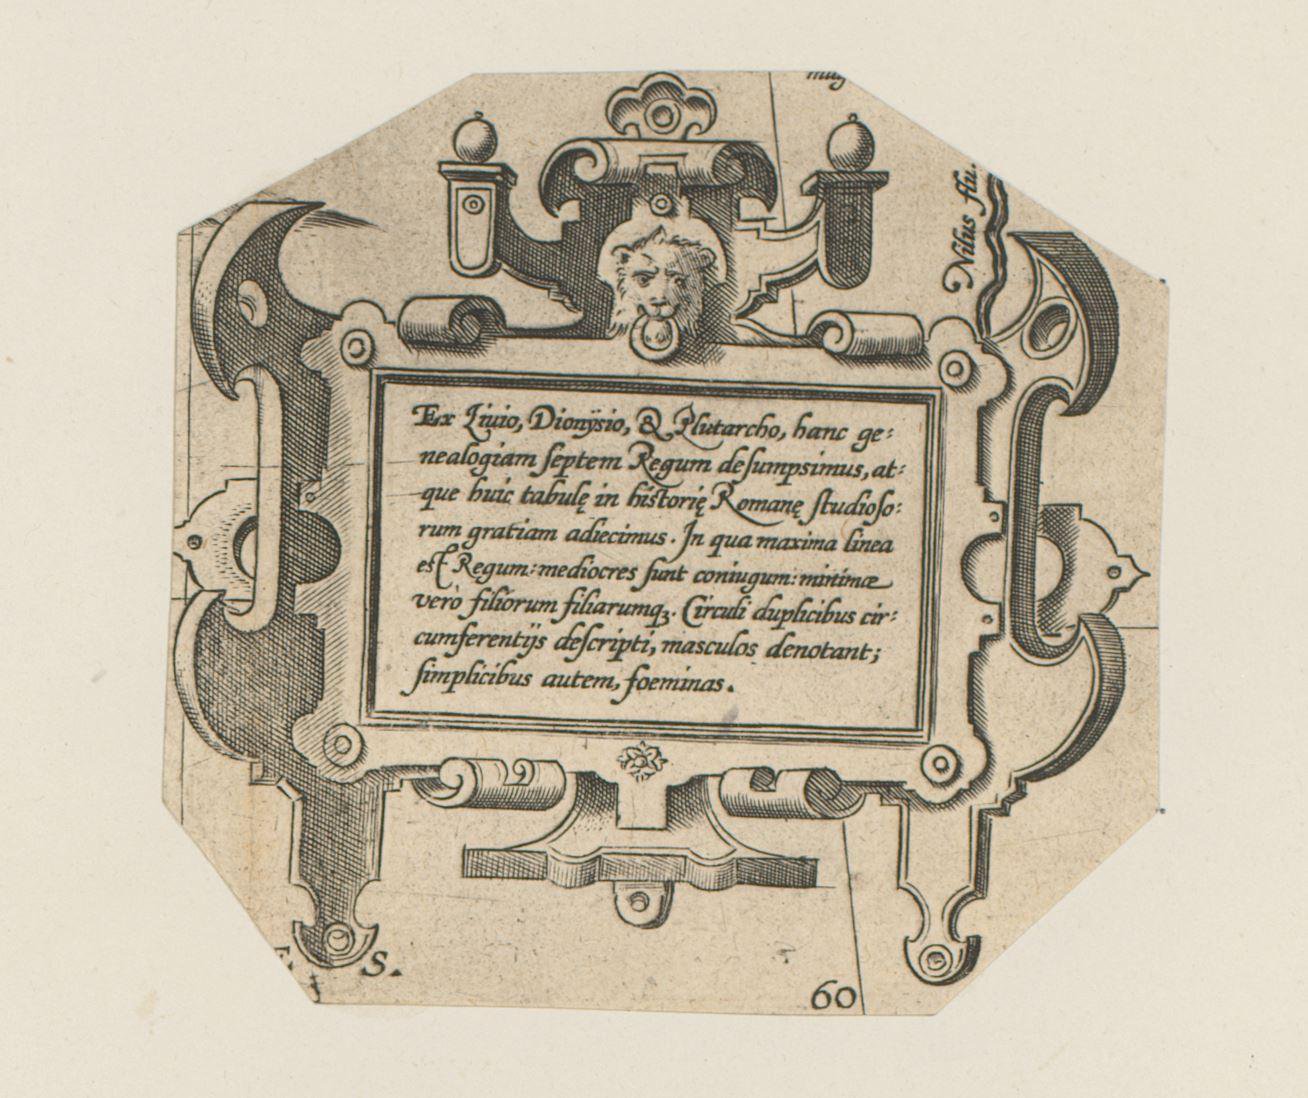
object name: ornament print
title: Rechthoekige cartouche met dierenmasker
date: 1579-1580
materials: paper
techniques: engraving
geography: antwerp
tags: ornament ~ cartouche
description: Rechthoekige cartouche met midden boven een dierenkop met een ring in zijn bek. De cartouche is een fragment van een kaart van het Romeinse Rijk. De prent maakt deel uit van een album.